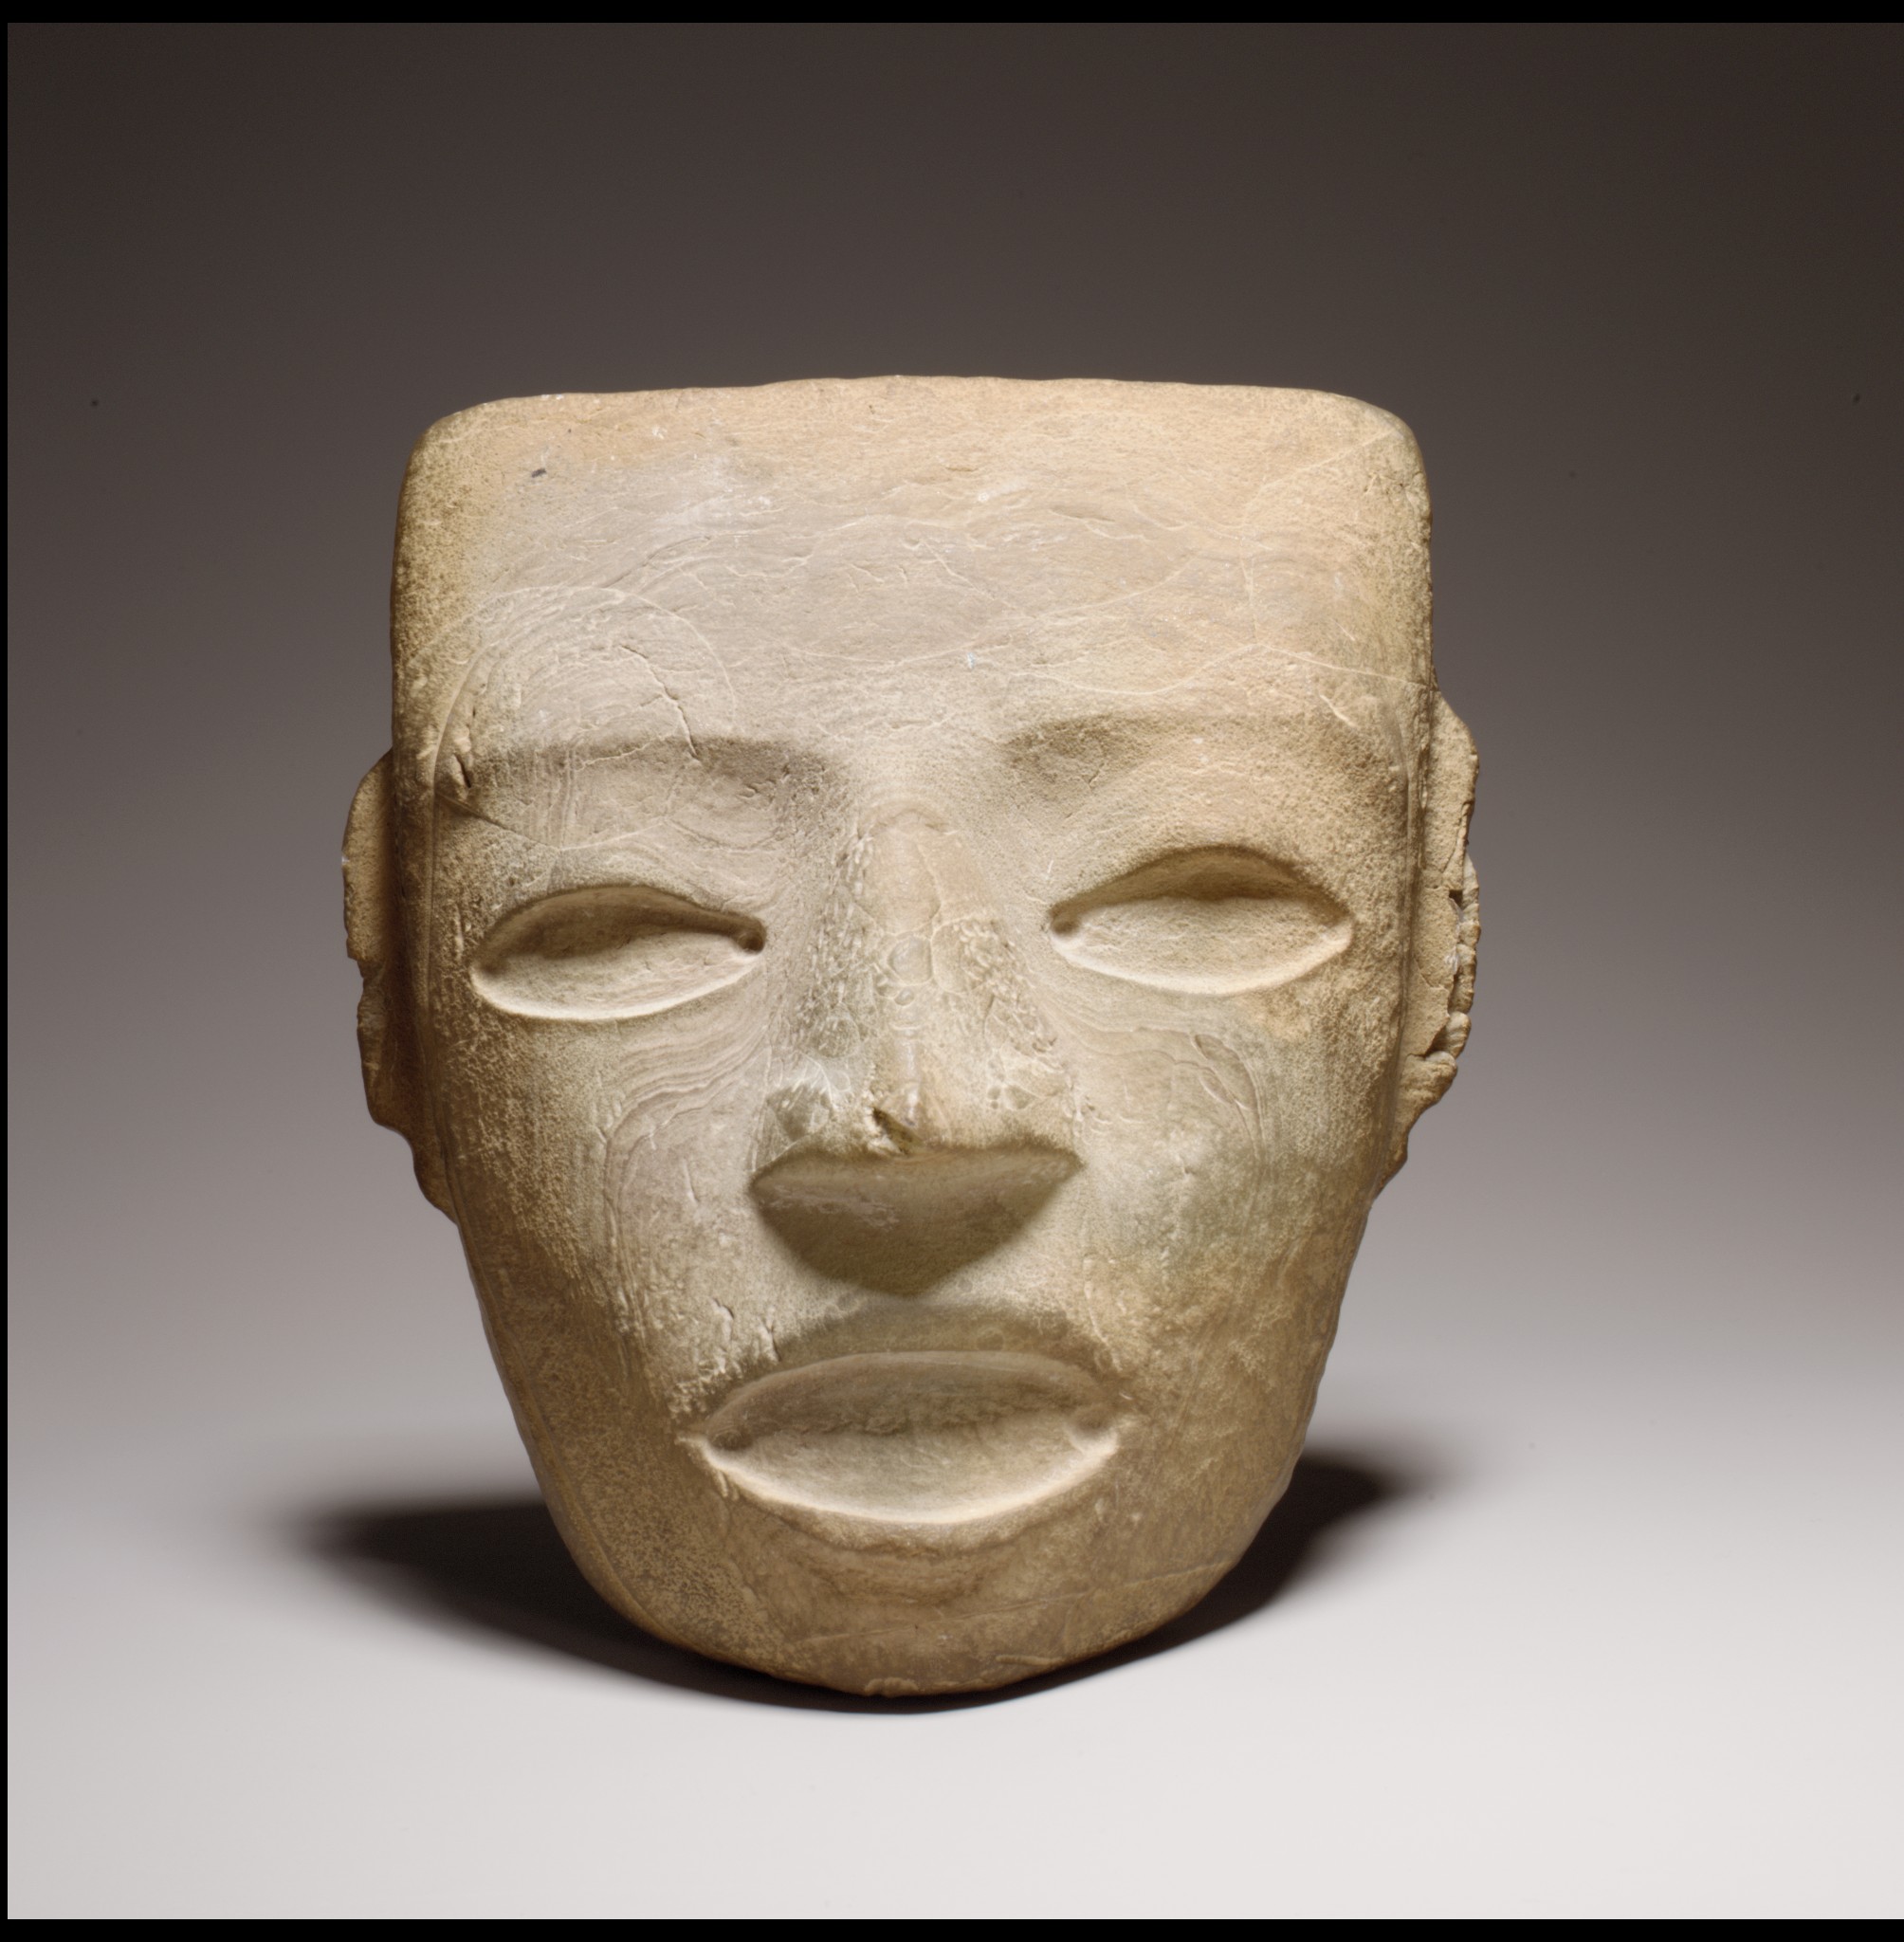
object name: mask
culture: teotihuacan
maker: teotihuacan artist(s)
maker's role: artist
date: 300-600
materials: stone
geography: mexico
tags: faces